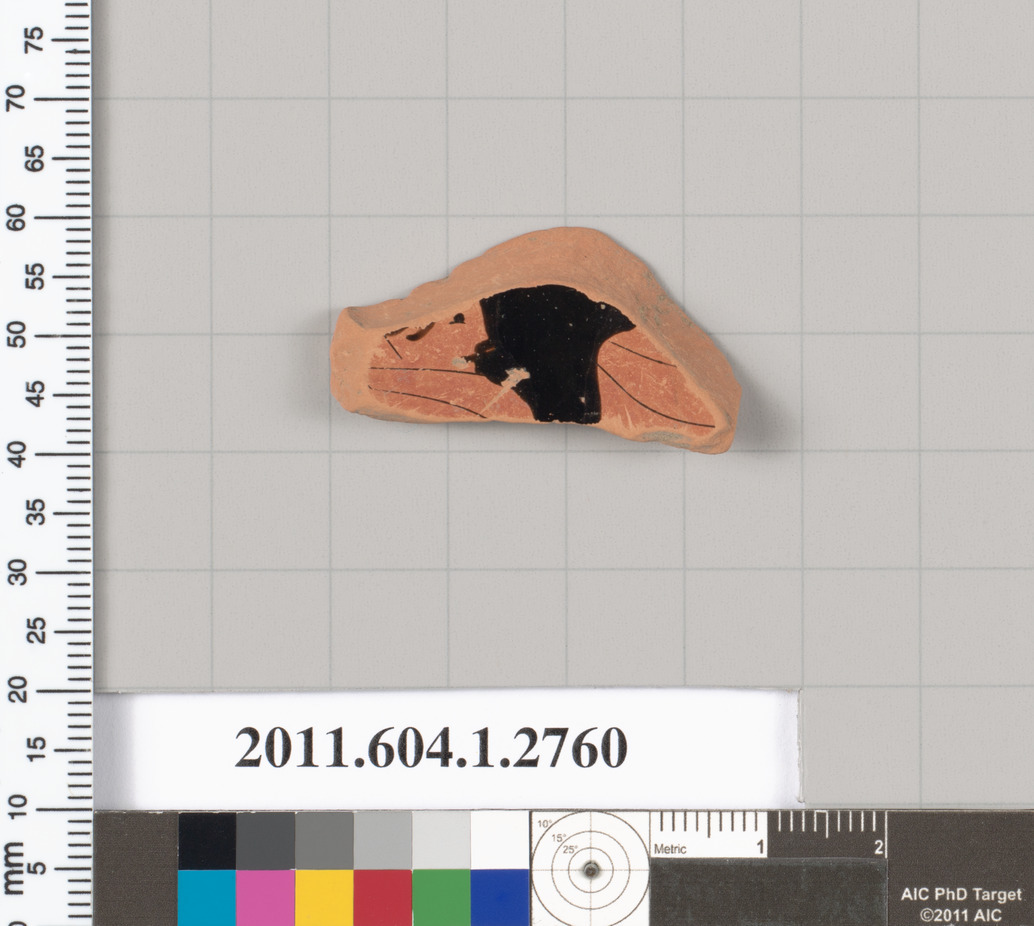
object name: kylix fragment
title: Terracotta fragment of a kylix (drinking cup)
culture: greek, attic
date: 460-450 BCE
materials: terracotta